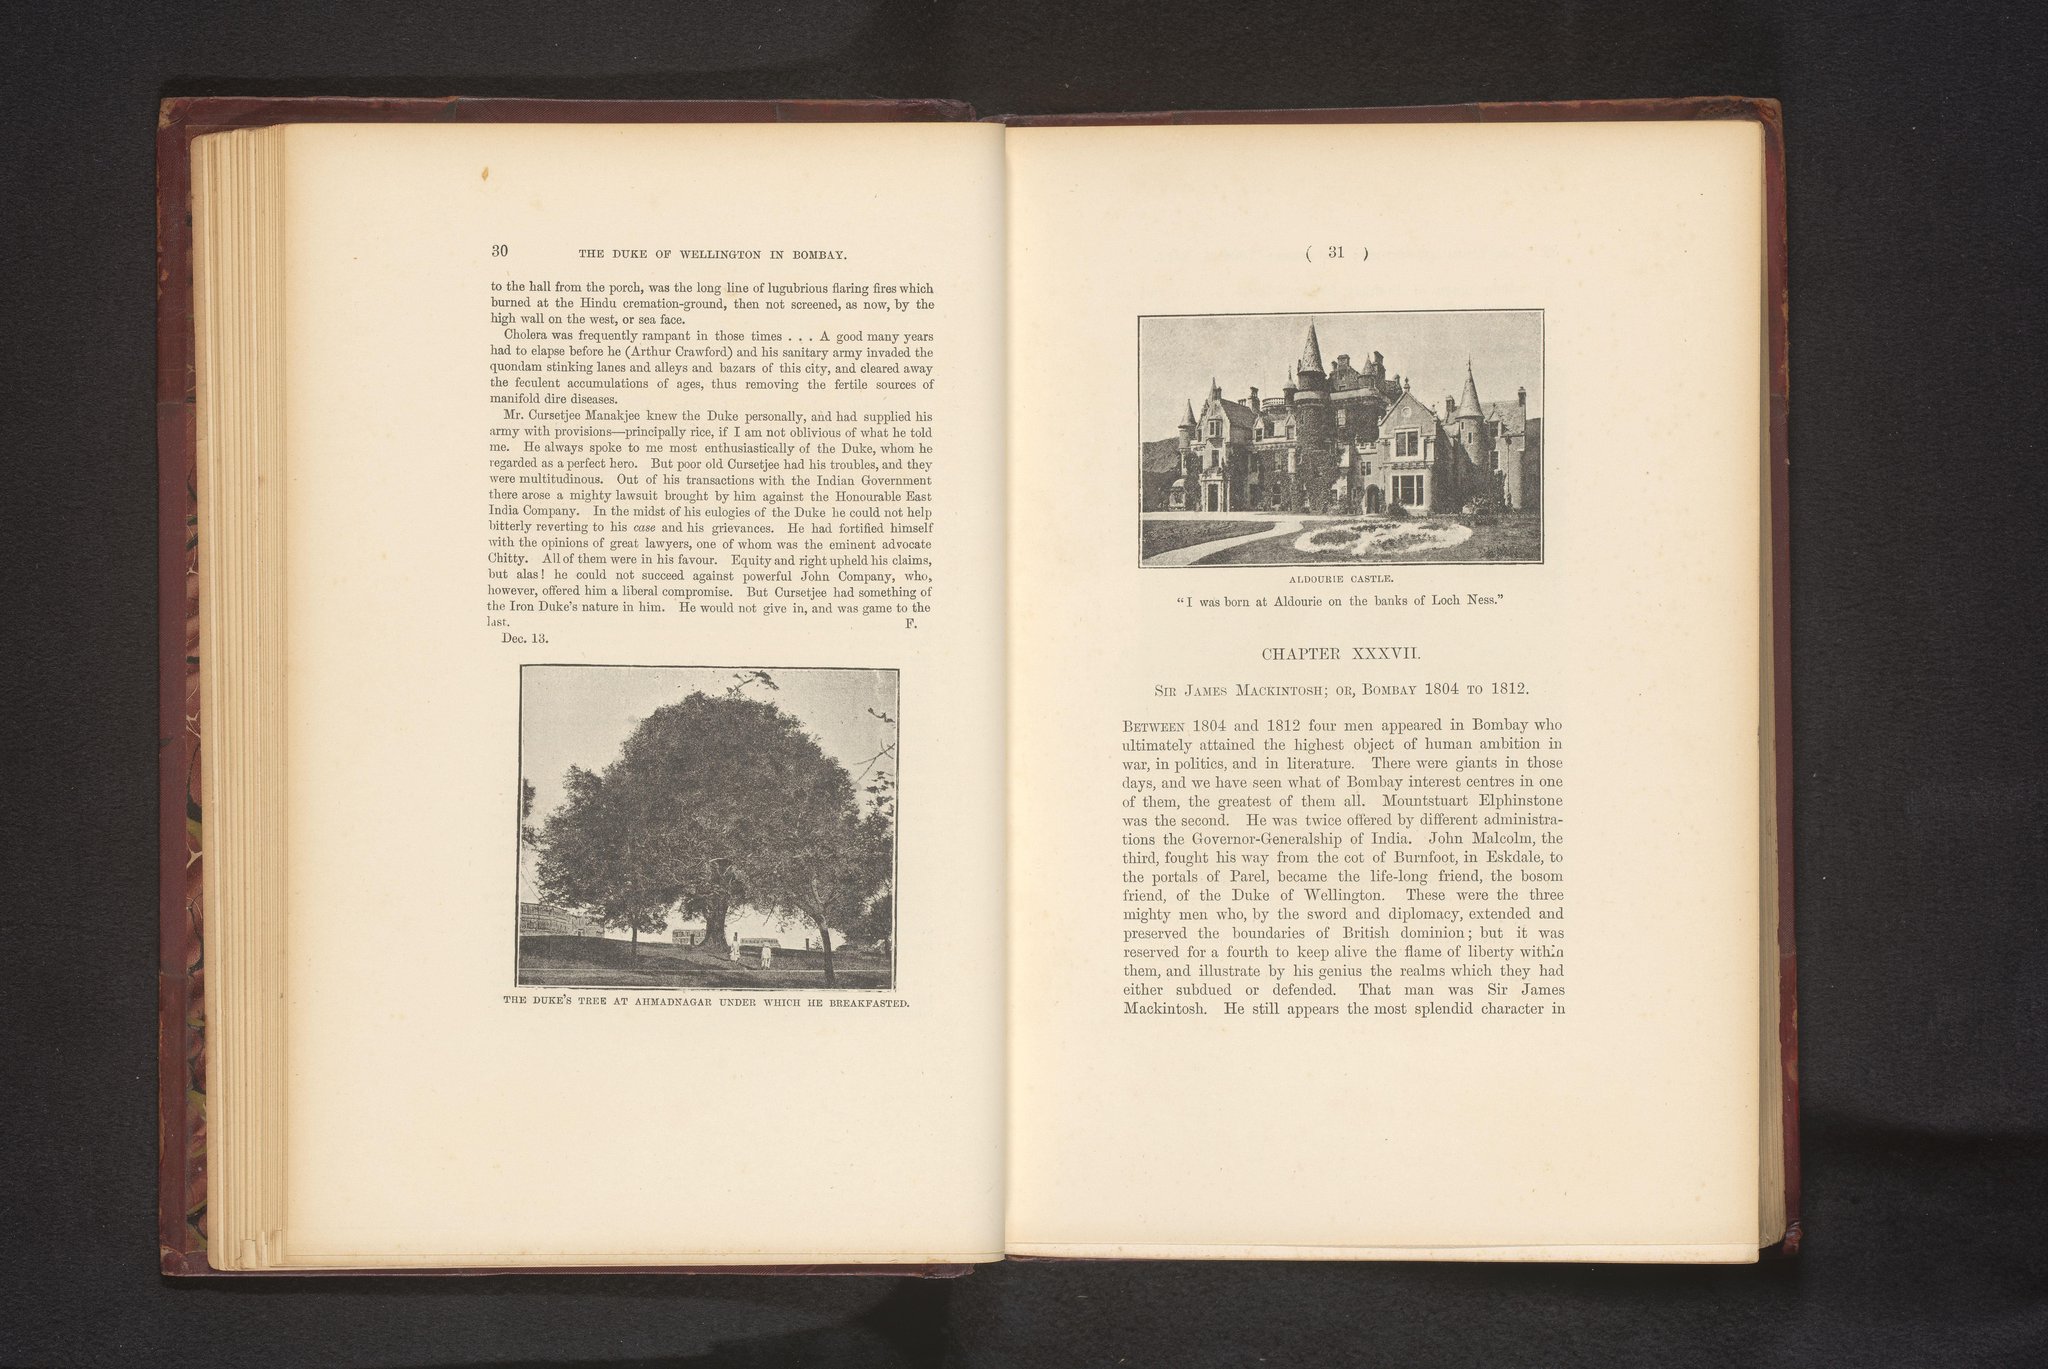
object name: page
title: The Duke's tree at Ahmadnagar under which he breakfasted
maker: Anonymous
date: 1883-1893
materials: paper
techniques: autotype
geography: paris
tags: trees